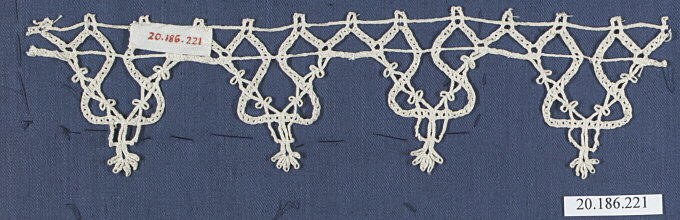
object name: edging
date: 1501-1600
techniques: lace